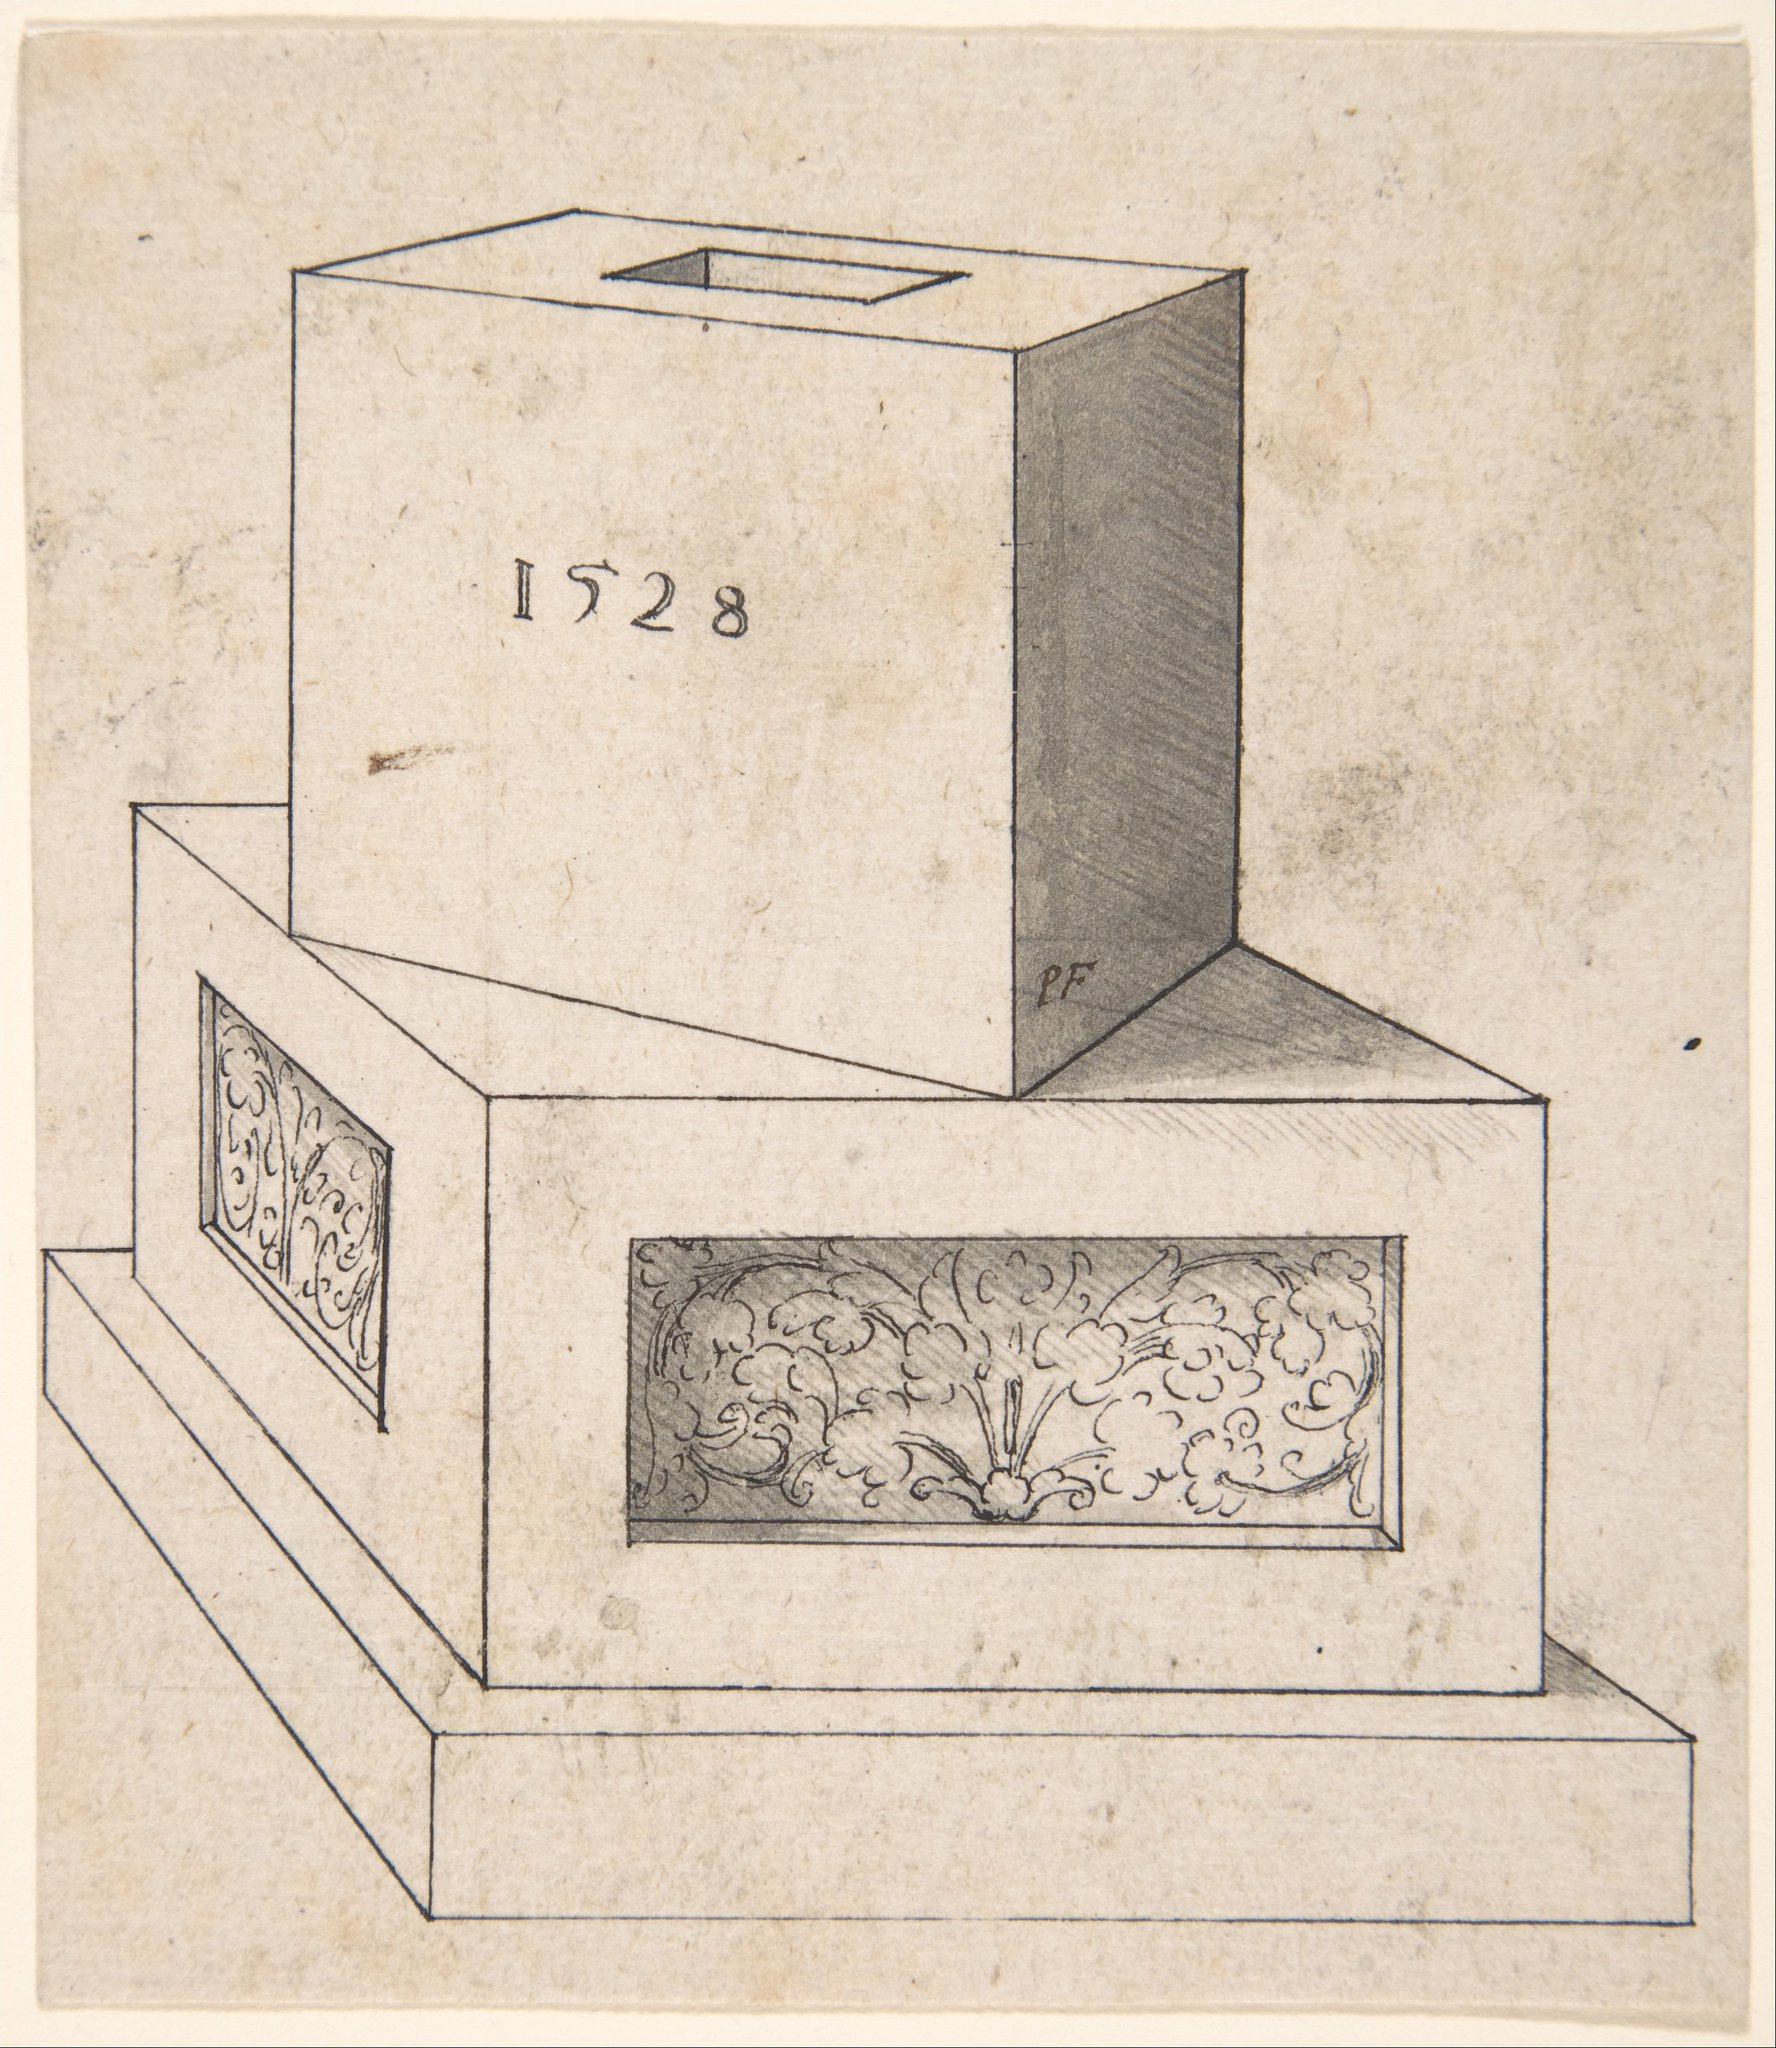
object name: drawing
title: Perspectival Drawing of a Column Base with Cube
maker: peter flötner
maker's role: artist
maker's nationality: german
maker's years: 1485-1546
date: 1528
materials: ink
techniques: brush, pen, wash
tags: architecture